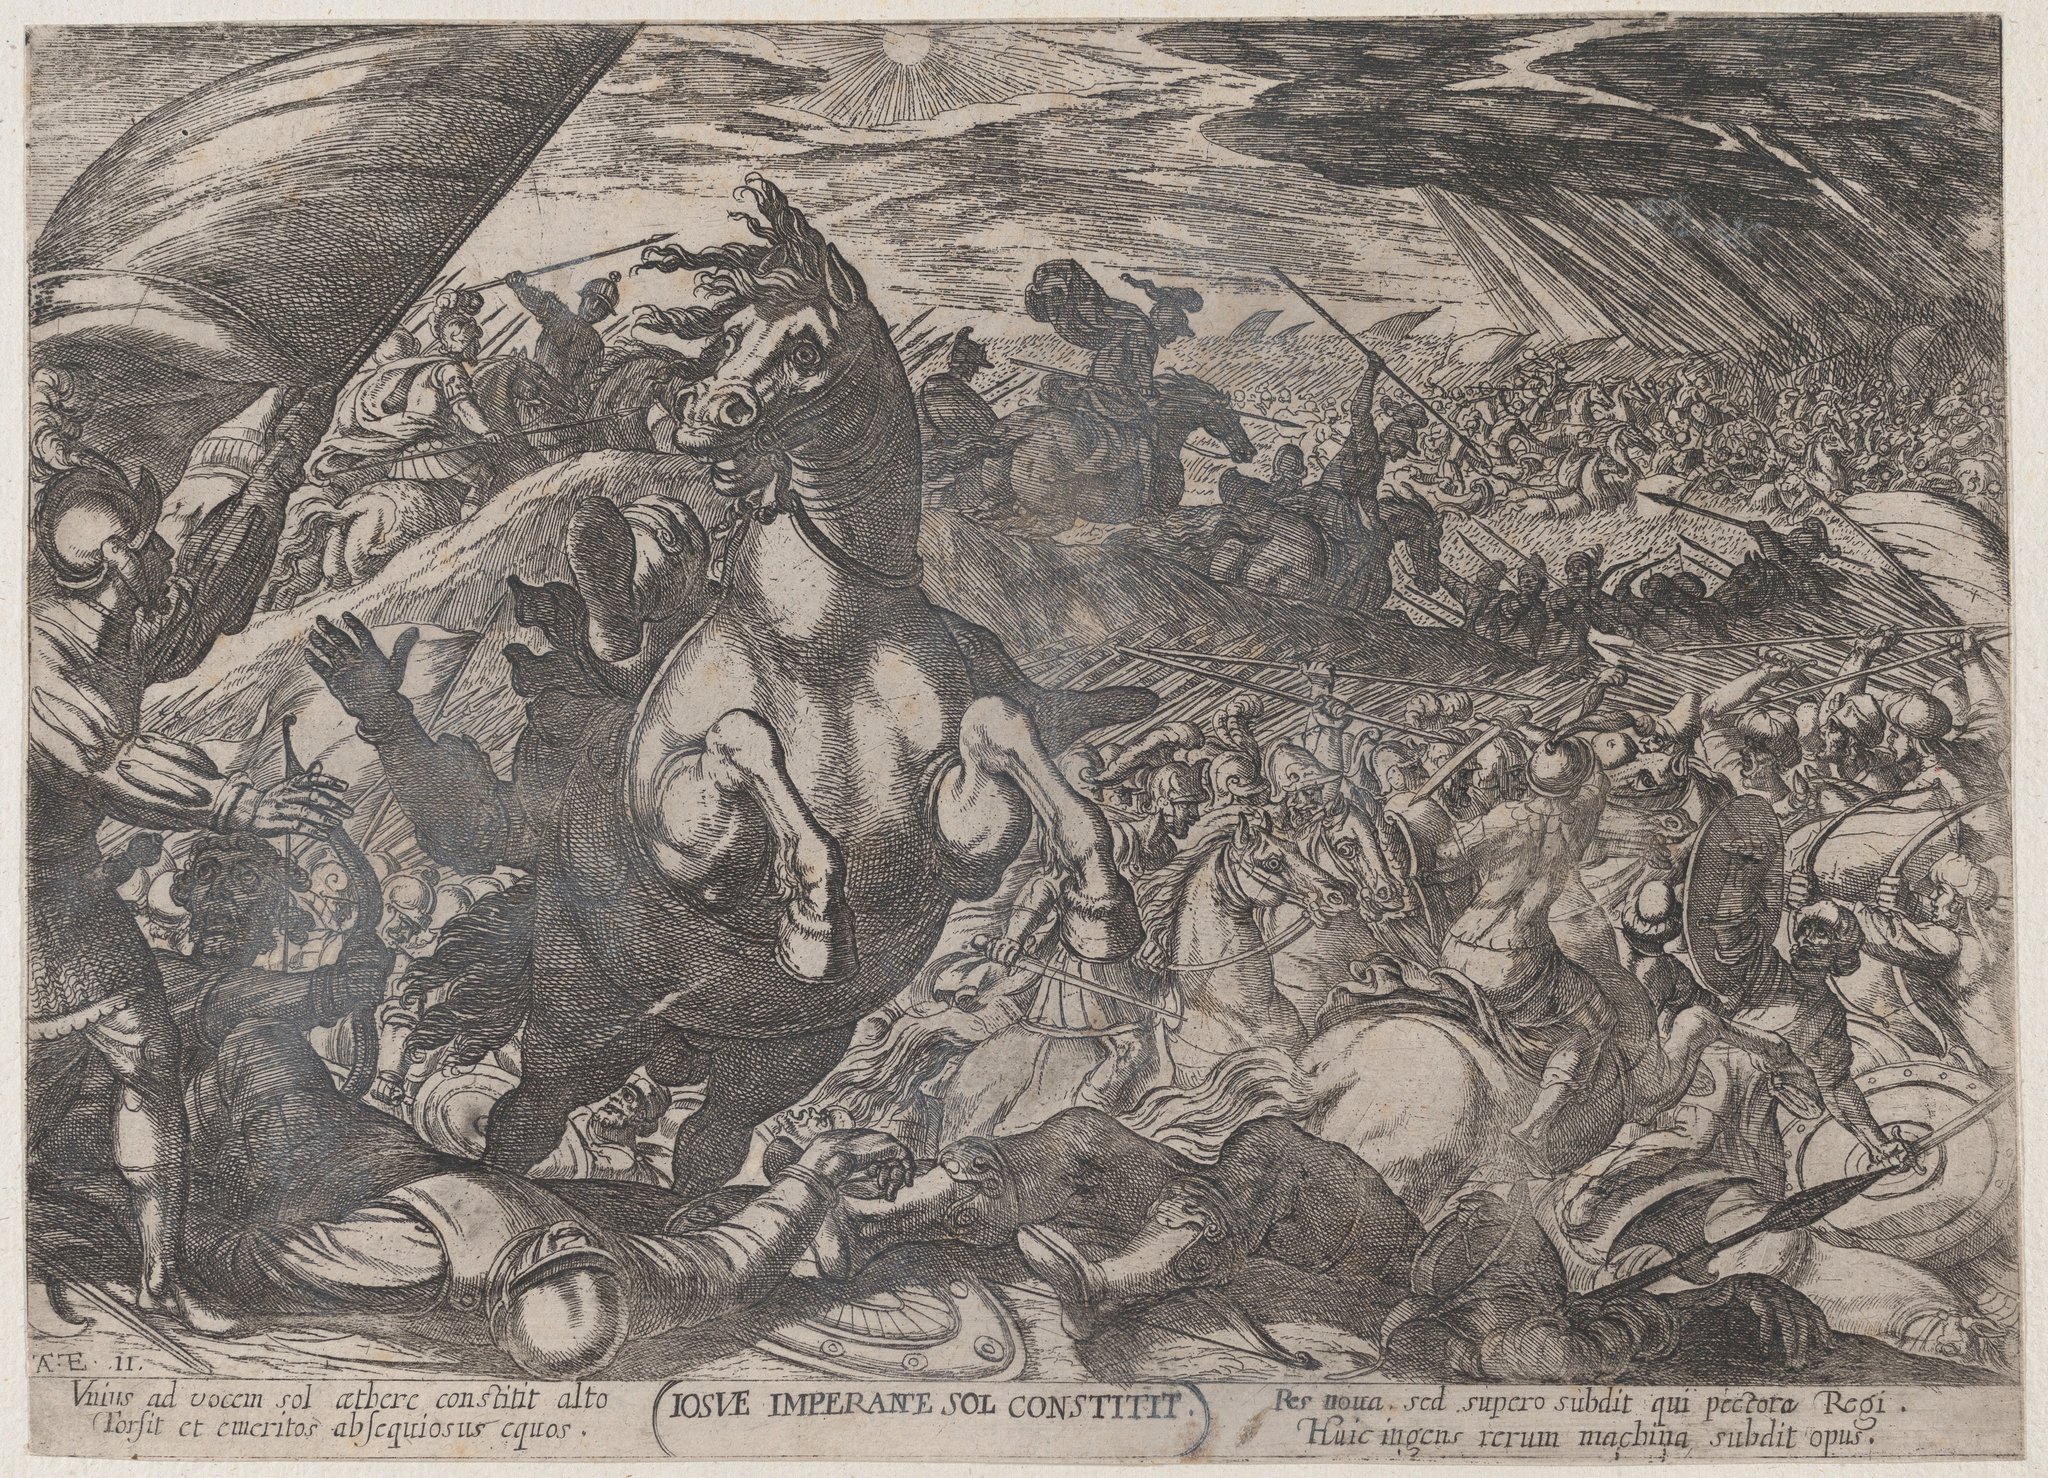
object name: print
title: Plate 11: Joshua Ordering the Sun to Stand Still, from "The Battles of the Old Testament"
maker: antonio tempesta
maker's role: artist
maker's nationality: italian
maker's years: 1555-1630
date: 1590-1610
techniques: etching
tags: battles,soldiers,weapons,horses